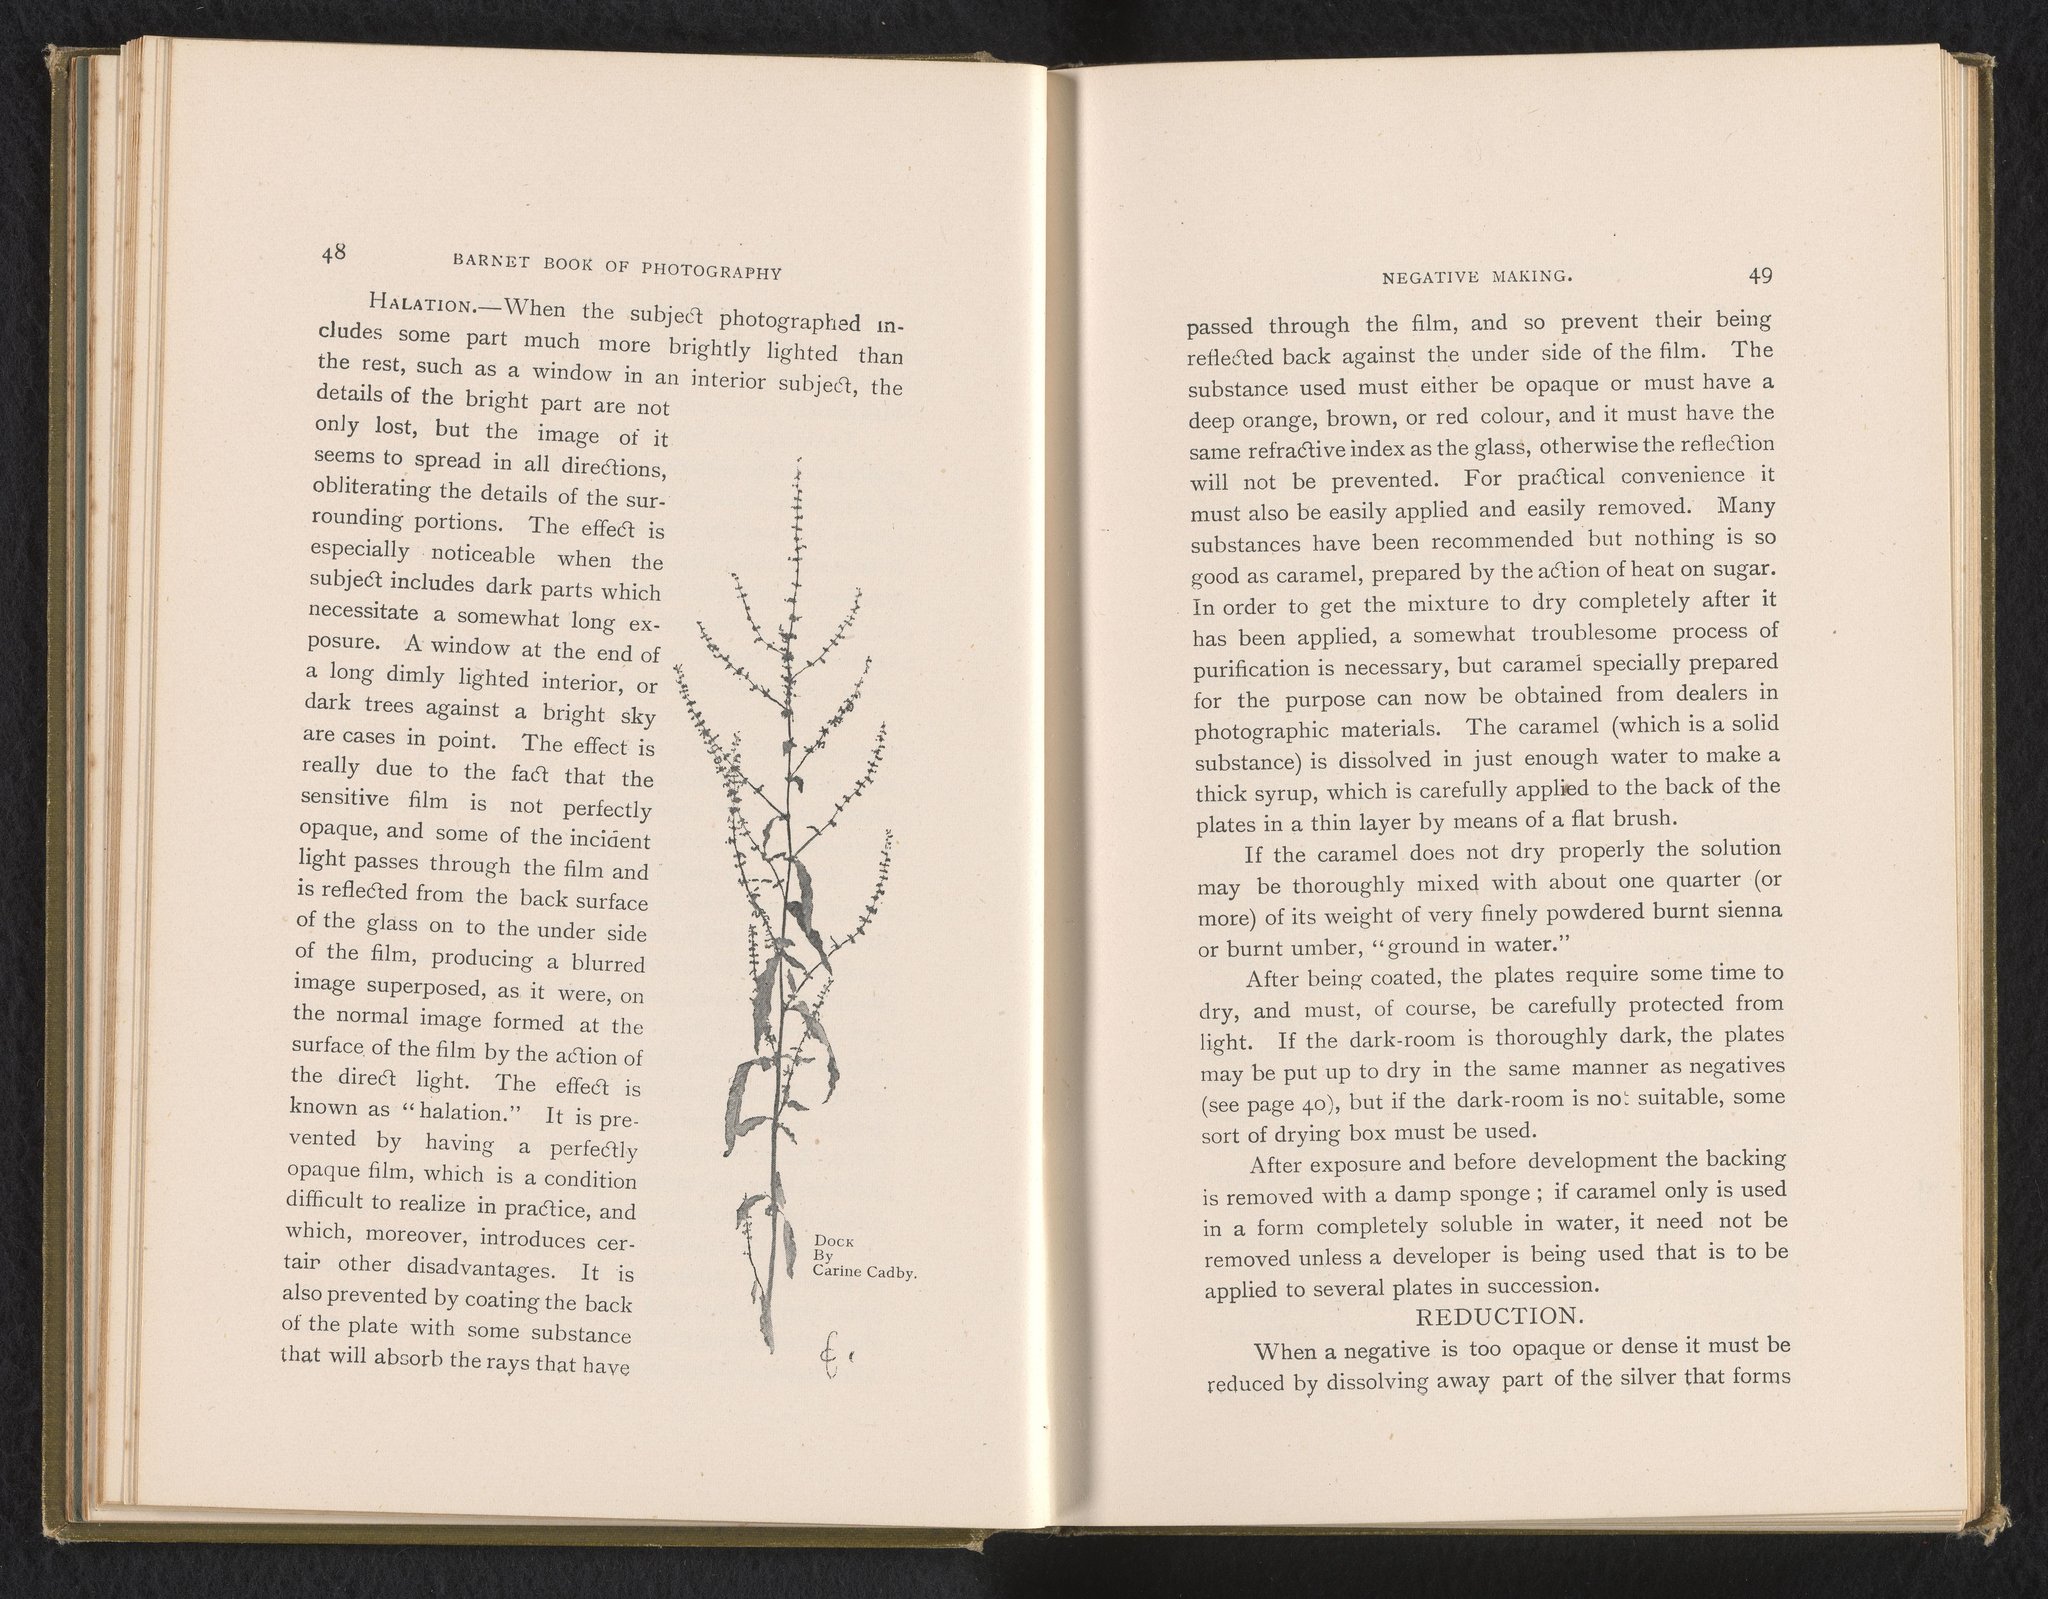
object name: photomechanical print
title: Krulzuring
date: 1895-1900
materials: paper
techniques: letterpress printing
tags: groups of plants (herbs)